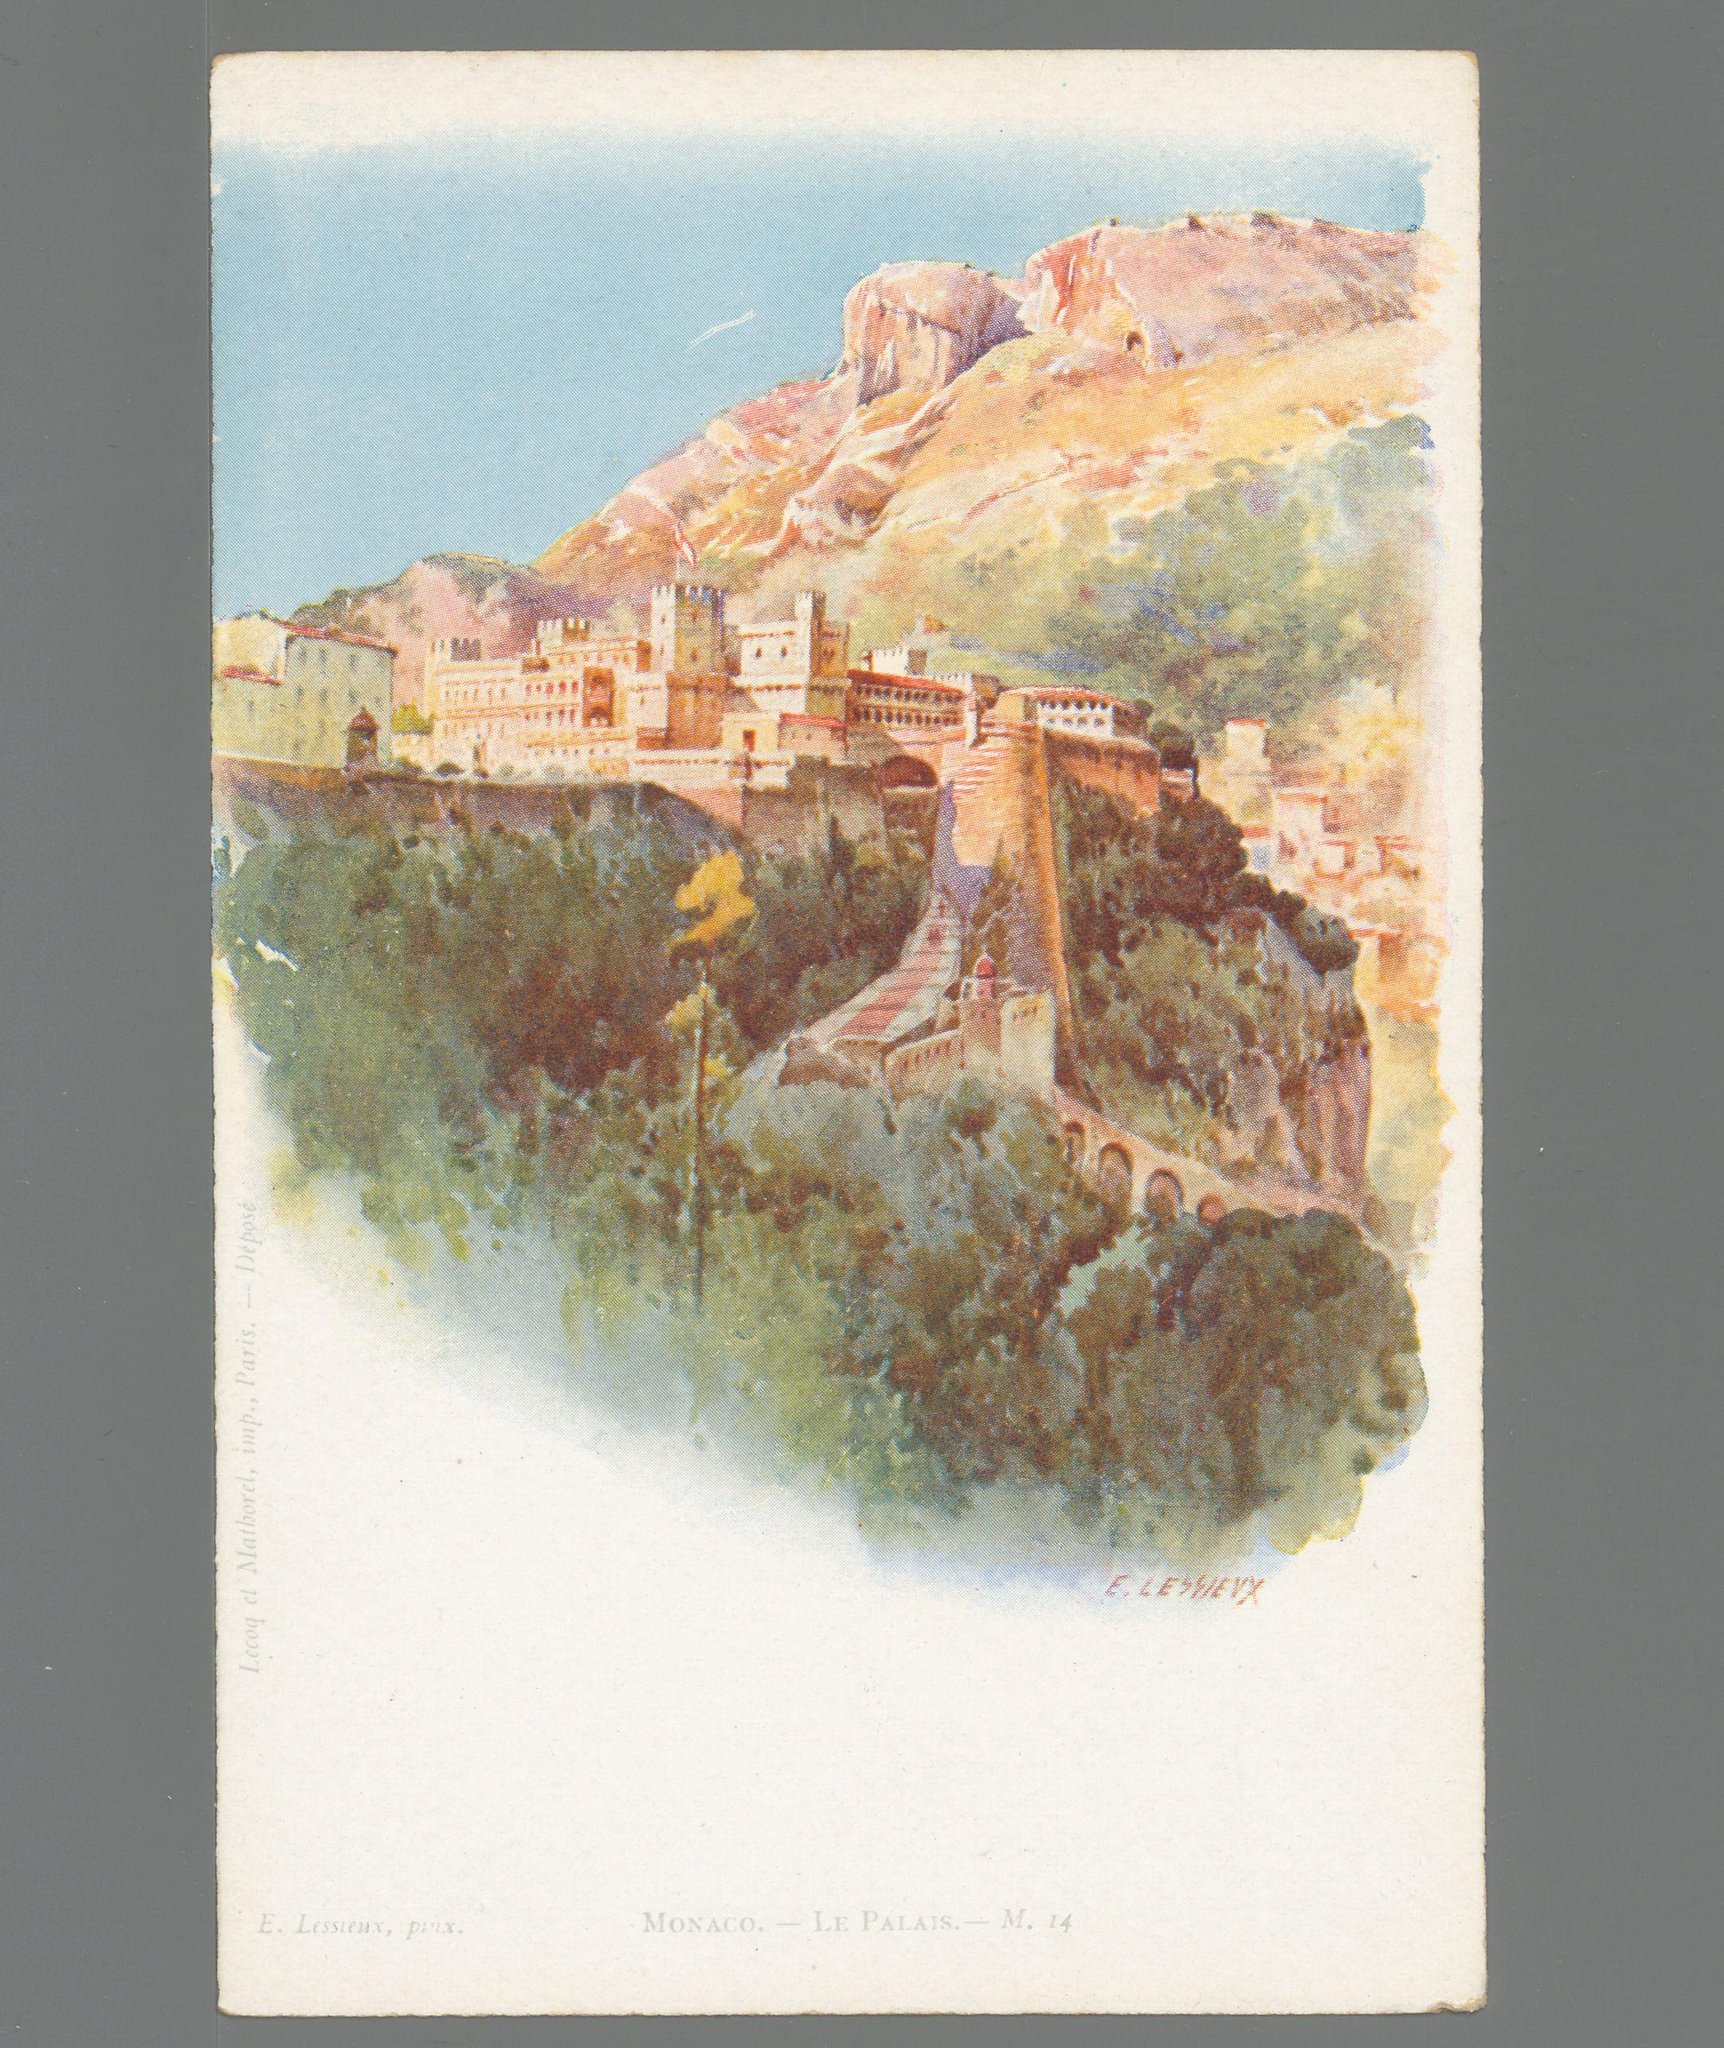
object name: ansichtkaart, prentbriefkaart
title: Menton, Monaco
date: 1892-1904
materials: cardboard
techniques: writing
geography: paris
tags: palace, mountains